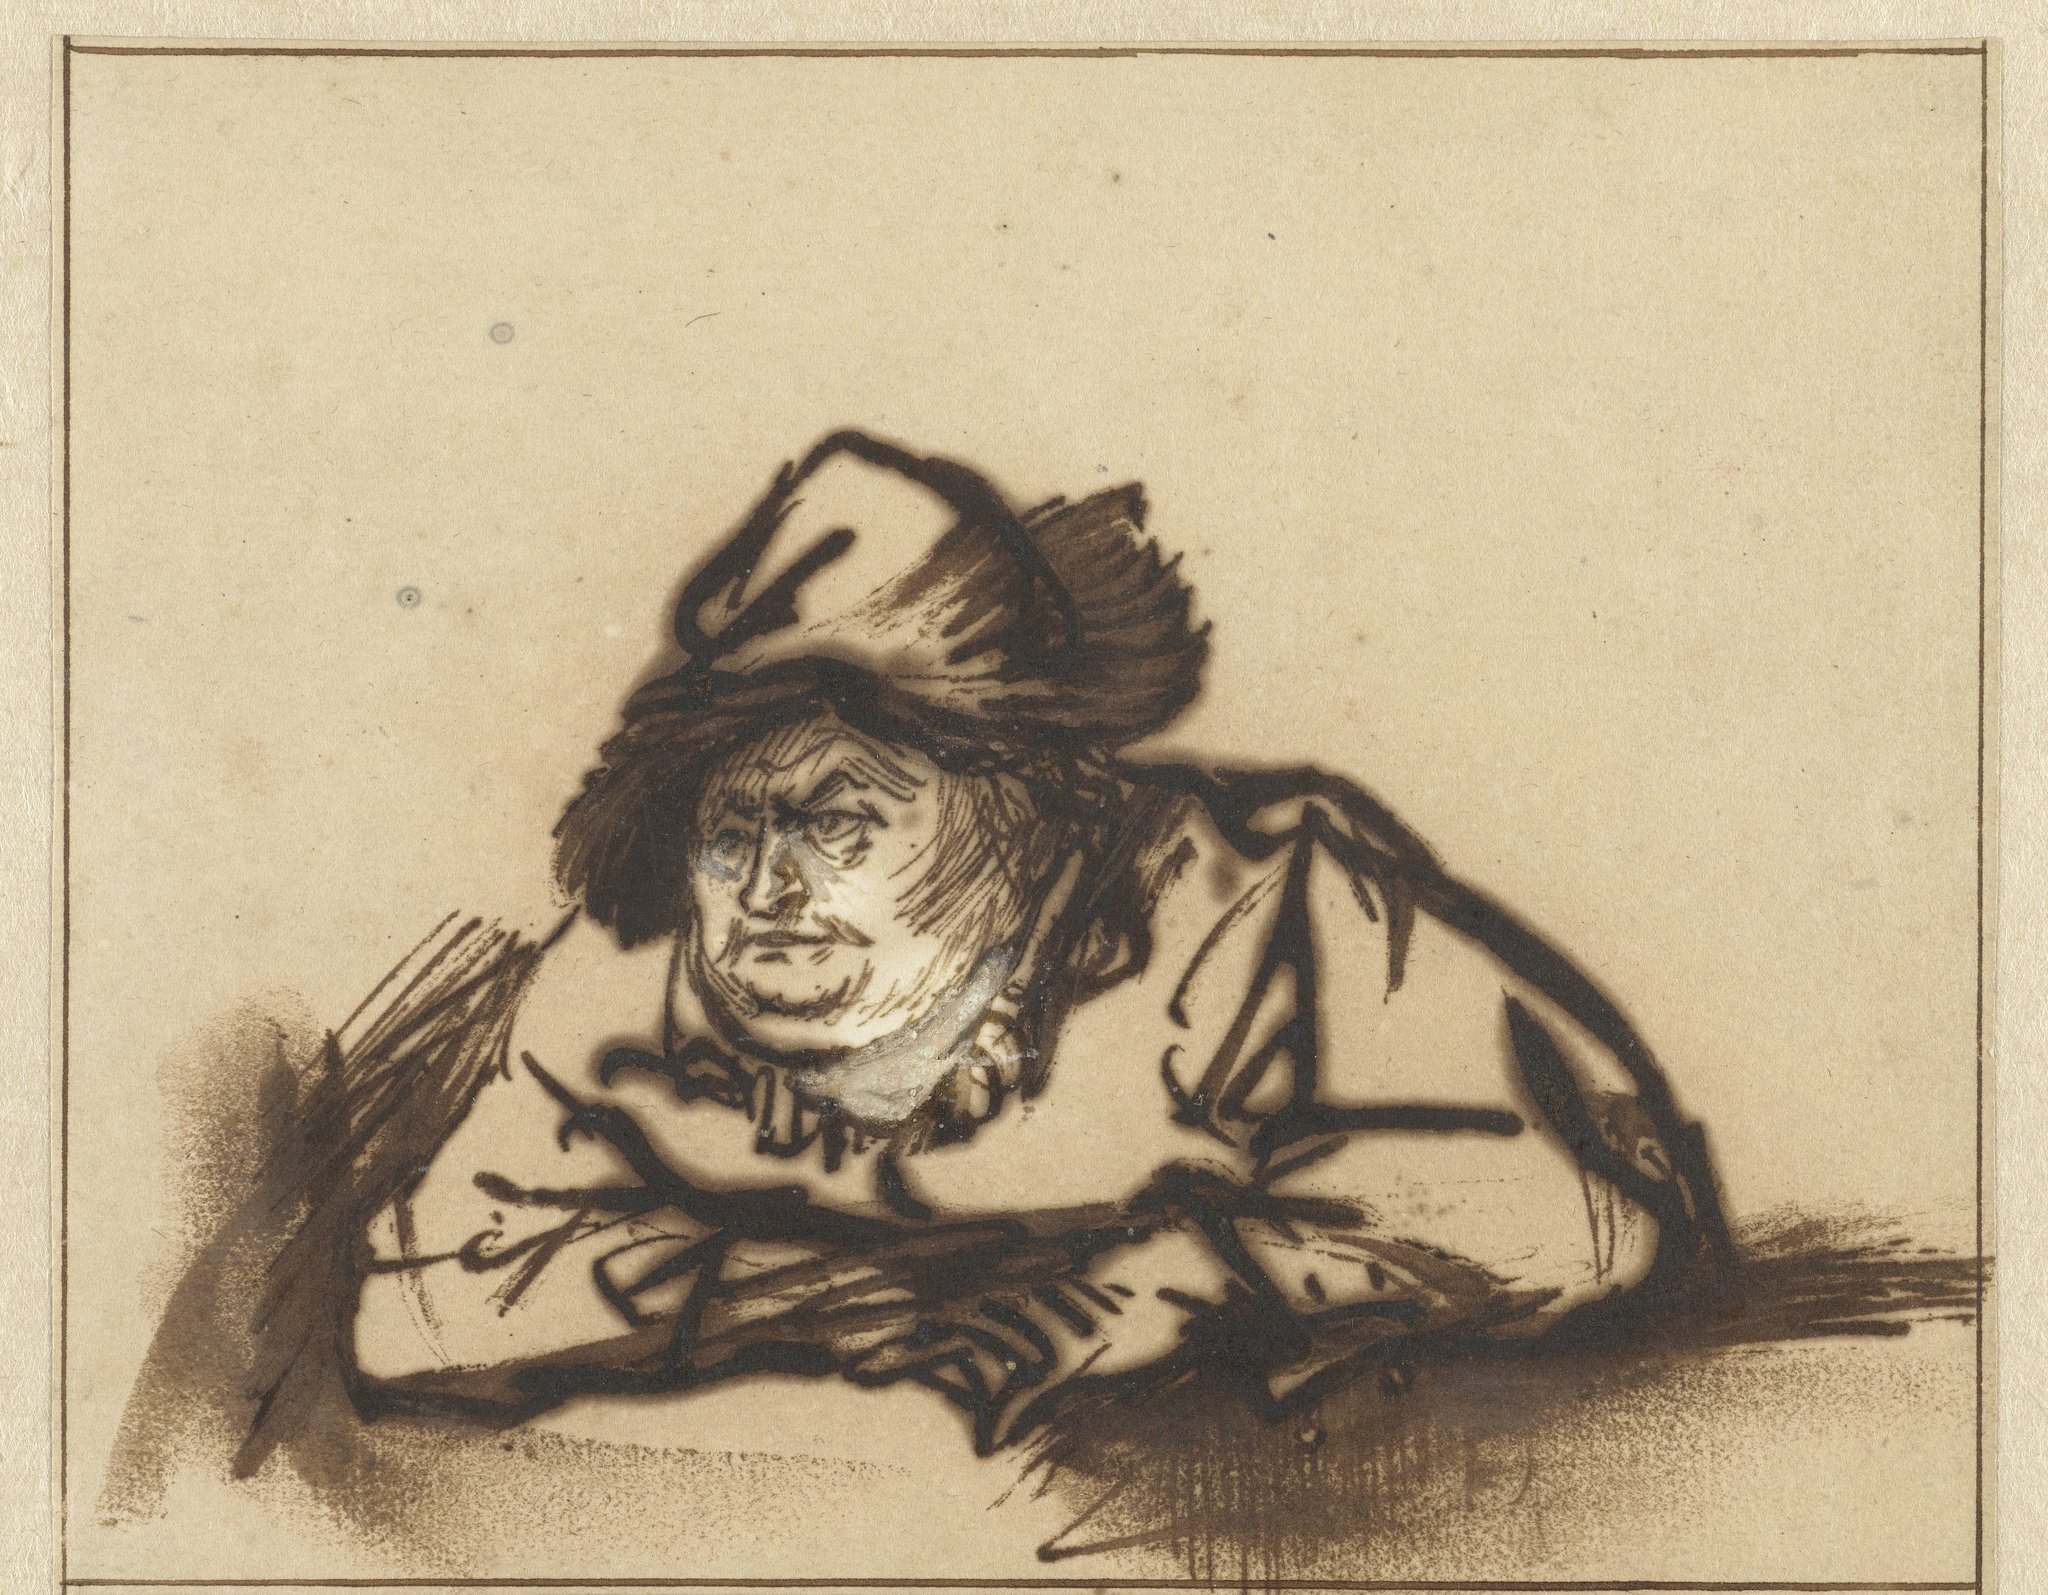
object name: drawing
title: The Actor Willem Bartholsz Ruyter as a Peasant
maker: rembrandt van rijn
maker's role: draughtsman, painter, print maker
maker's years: 1606-1669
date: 1638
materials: paint, ink, paper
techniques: pen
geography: amsterdam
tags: dordrecht, portrait of actor, actress, amsterdam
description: Willem Bartholsz Ruyter (1587-1639) was a famous actor in Amsterdam. One drawing shows him as King Ahasuerus, who has just heard from his Jewish wife, Esther, that his confidant Haman had ordered the death of all Jews. In the second study, he wears the costume of a country yokel who was the central figure in popular farces called ‘boertigheden’.